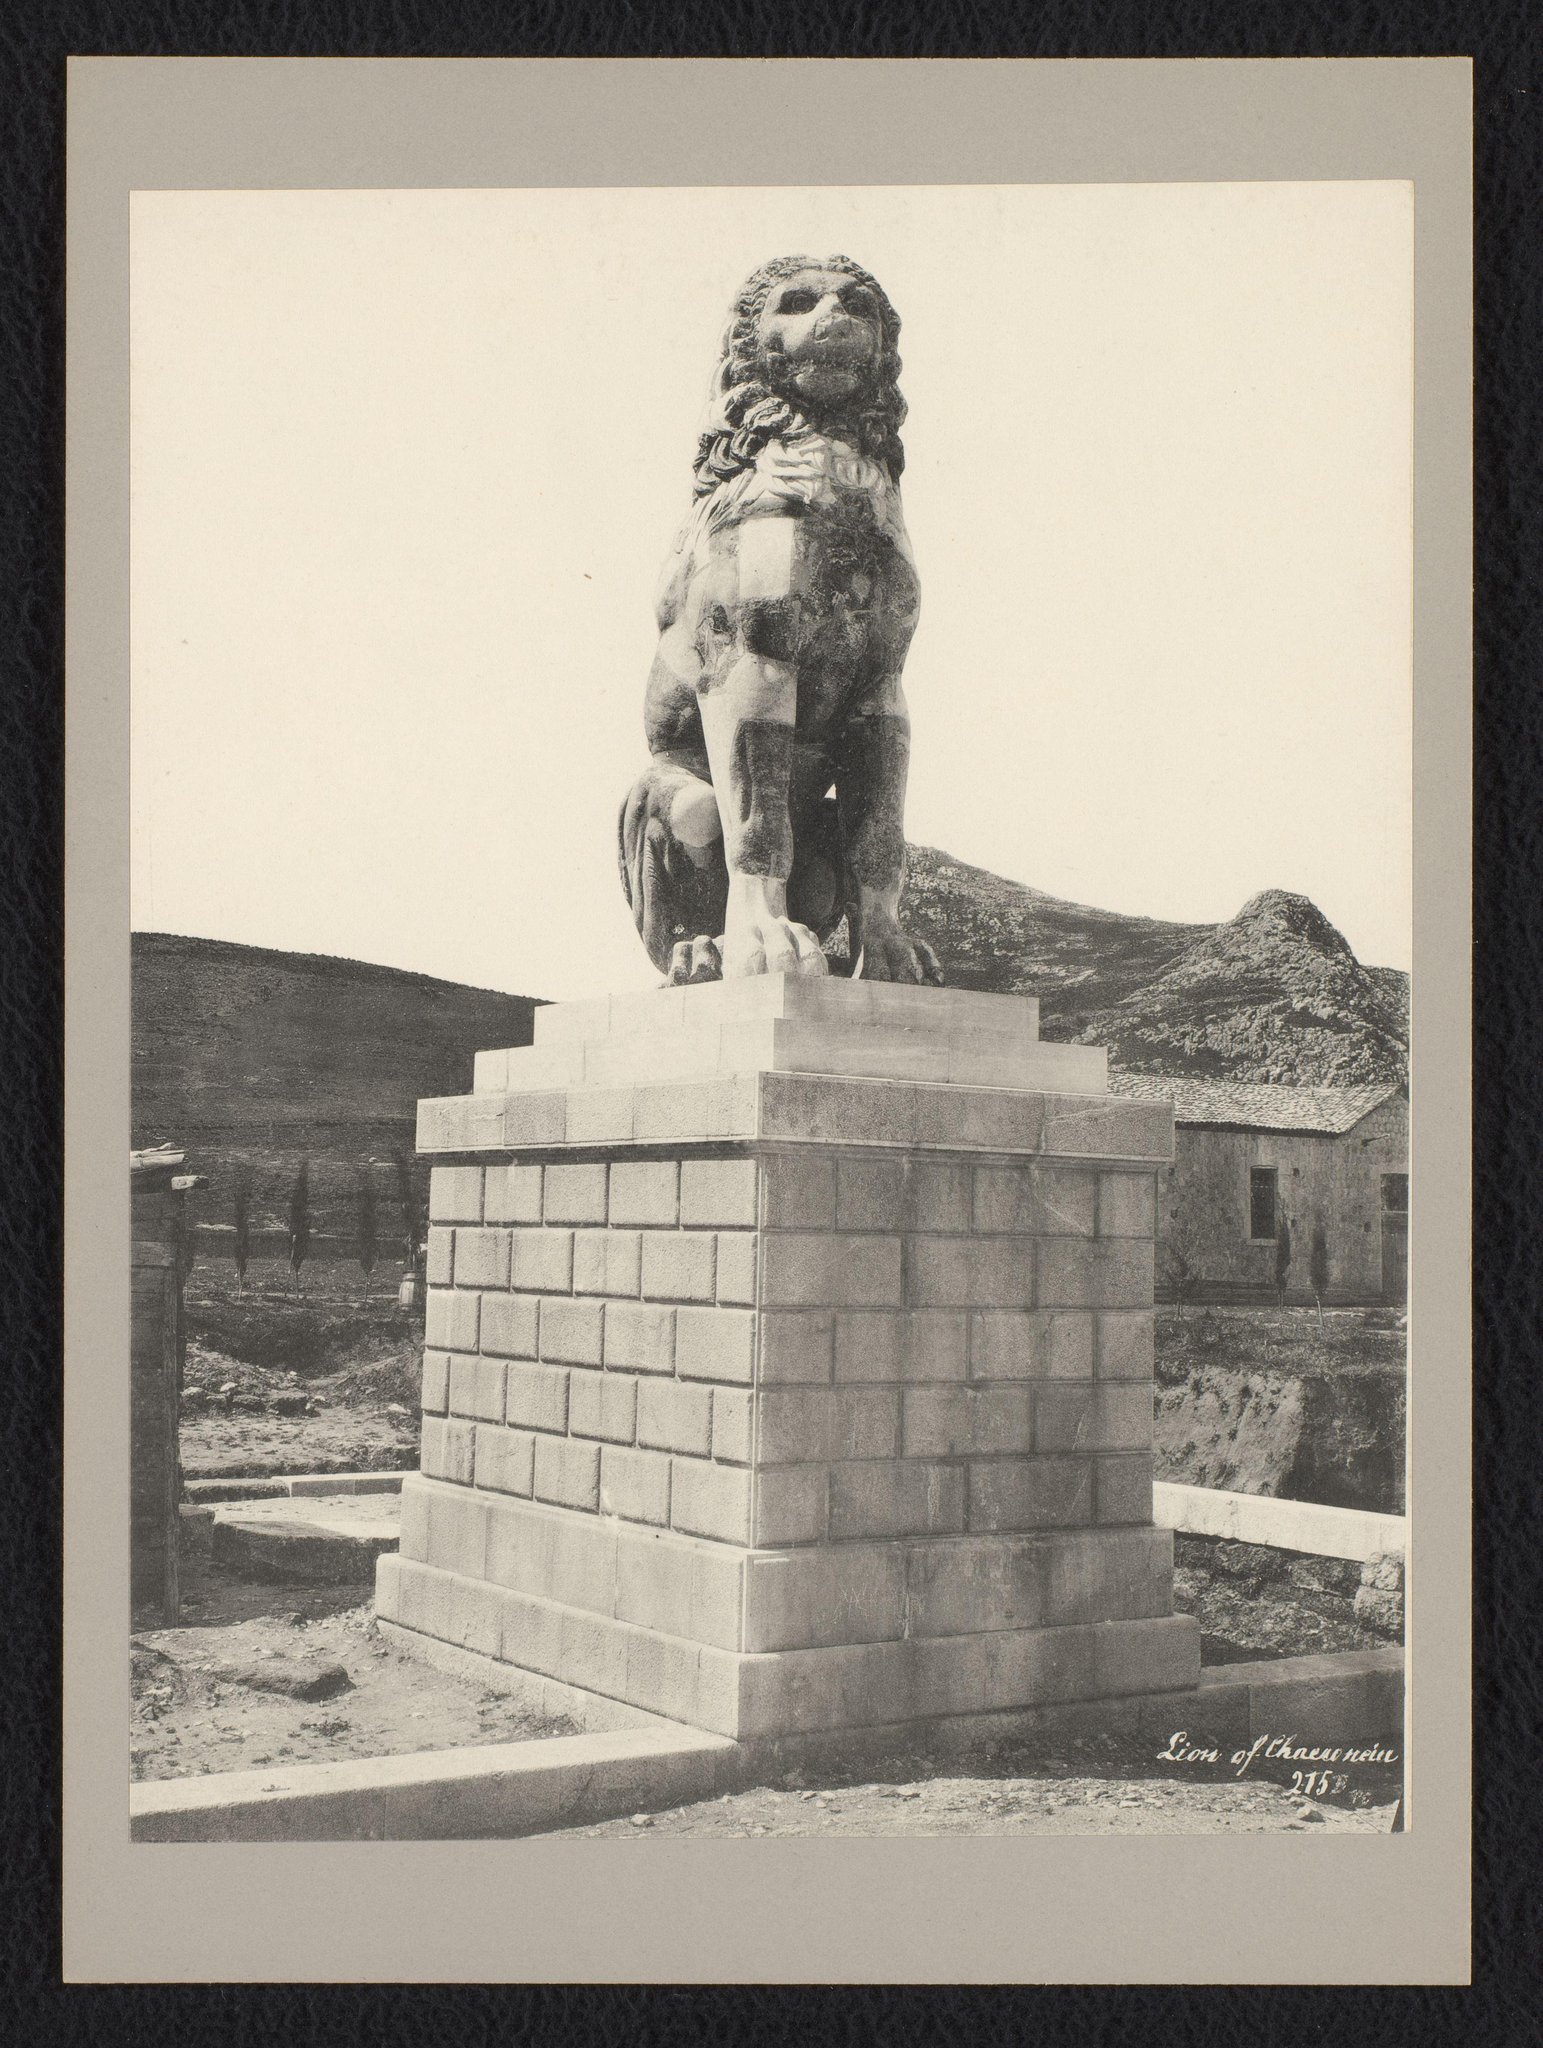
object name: photograph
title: Beeld van Leeuw op voetstuk in Chaeronea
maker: Anonymous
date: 1895-1915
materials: cardboard, paper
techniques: photograph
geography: chaeronea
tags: chaironeia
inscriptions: annotation: ‘21. Leeuw te Gerònea; opgericht door Filips van Macedonië ter eere zijner overwinning op de Atheners 338 vóór Chr.’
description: Leeuw opgericht door Filips van Macedonië ter ere van zijn overwinning op de Atheners in 338 vóór Christus.